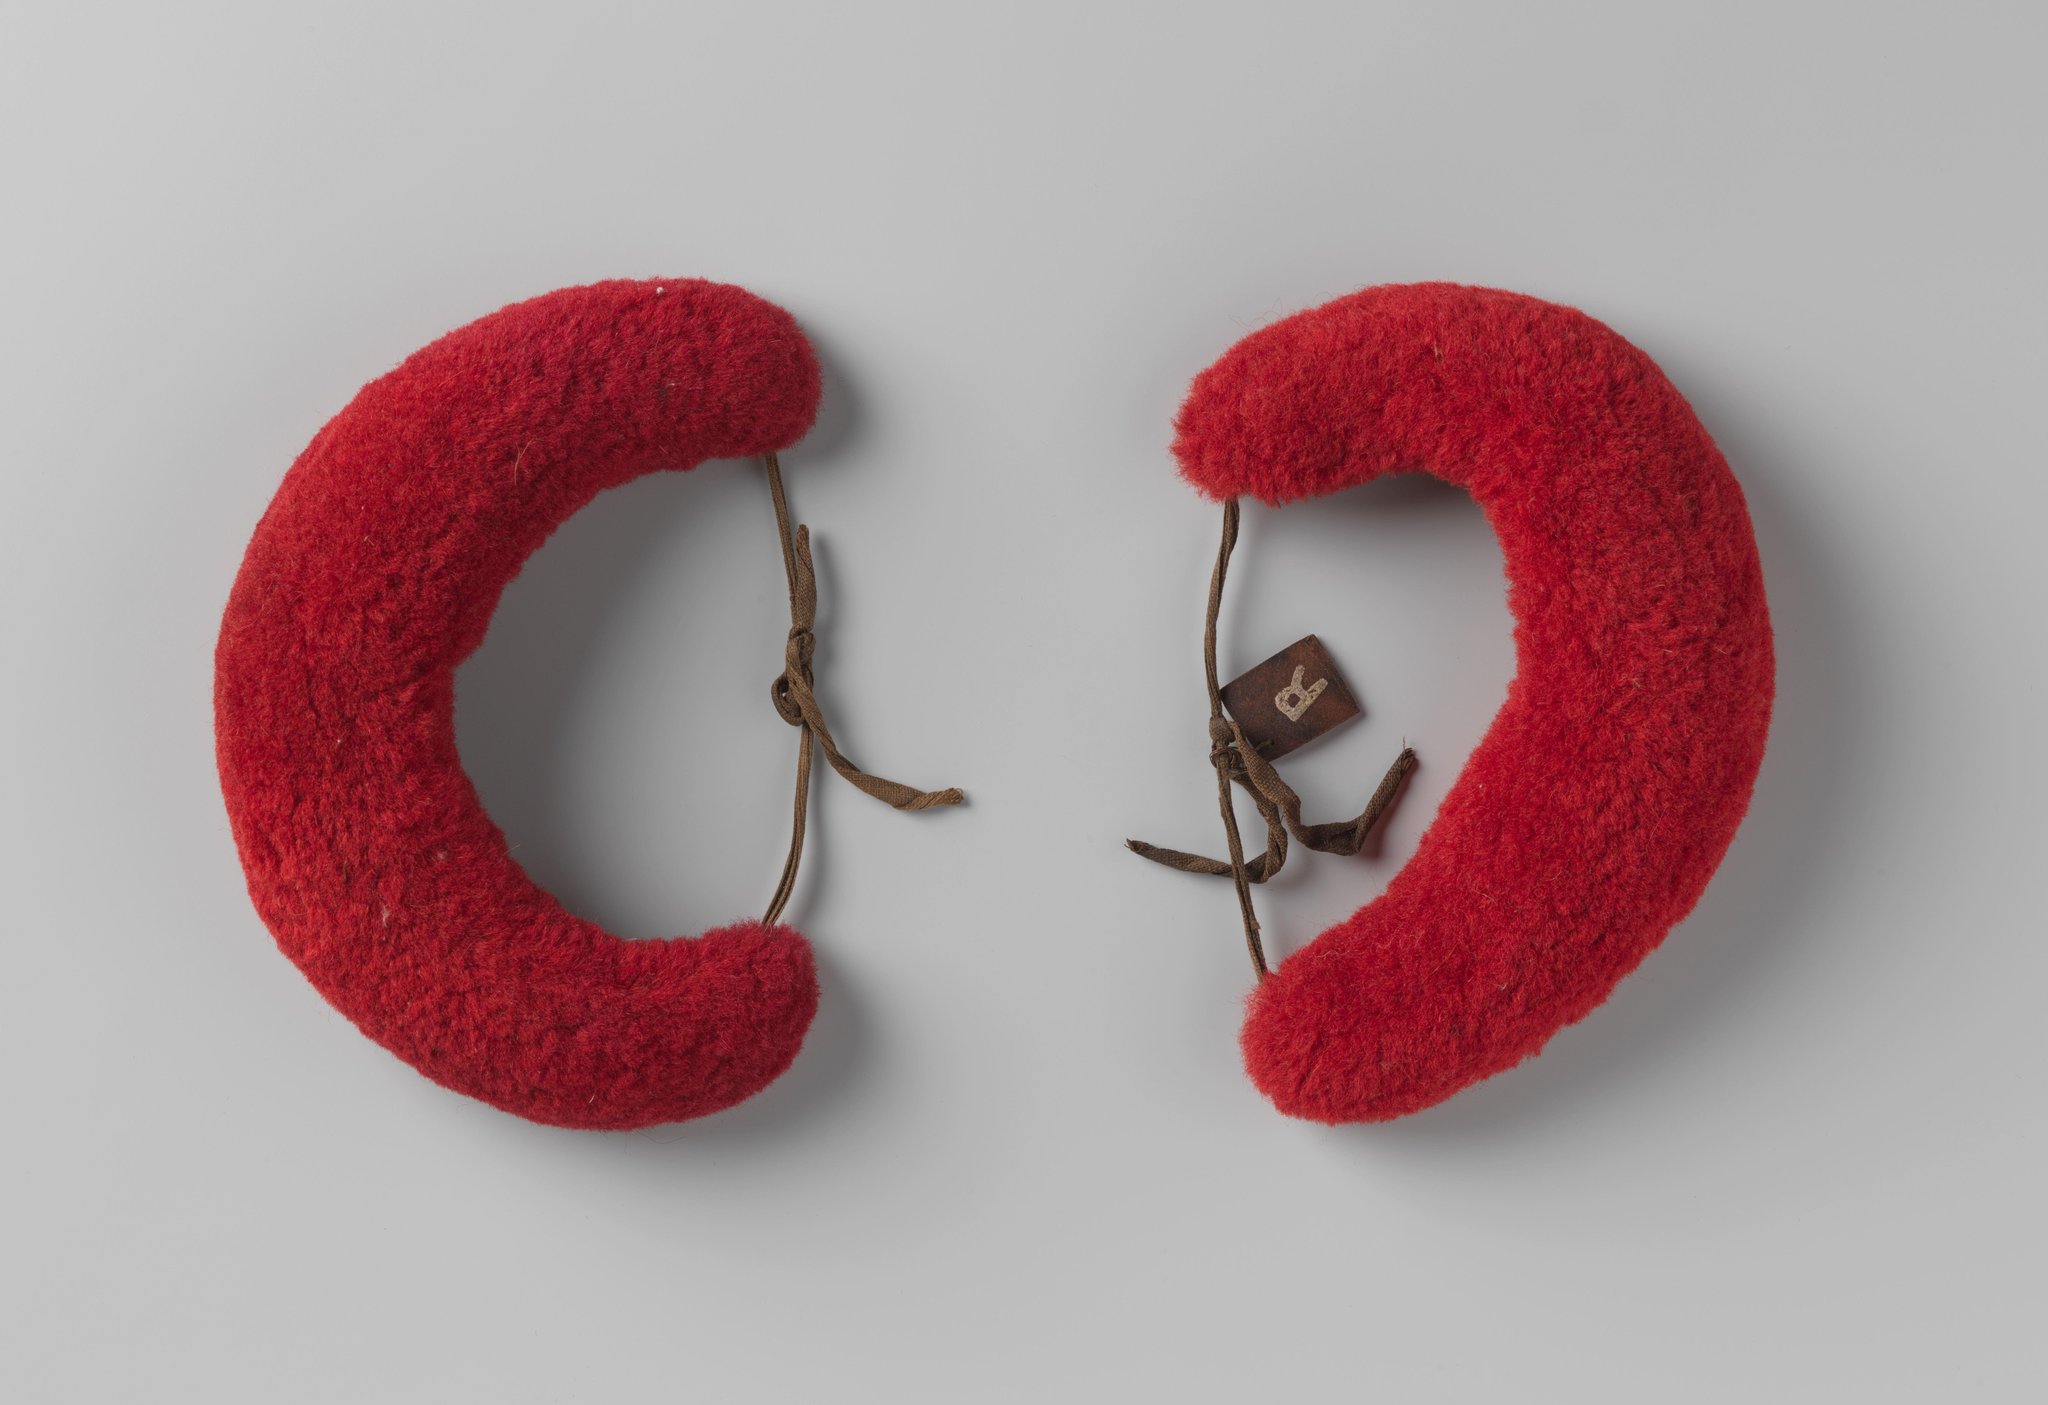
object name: wing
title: Wings voor schutters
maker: Anonymous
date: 1840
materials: textile, hair, wool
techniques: stitching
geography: netherlands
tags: netherlands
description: Schouderbedekking, halfrond van vorm, van rode wol met grijze lakense voering.